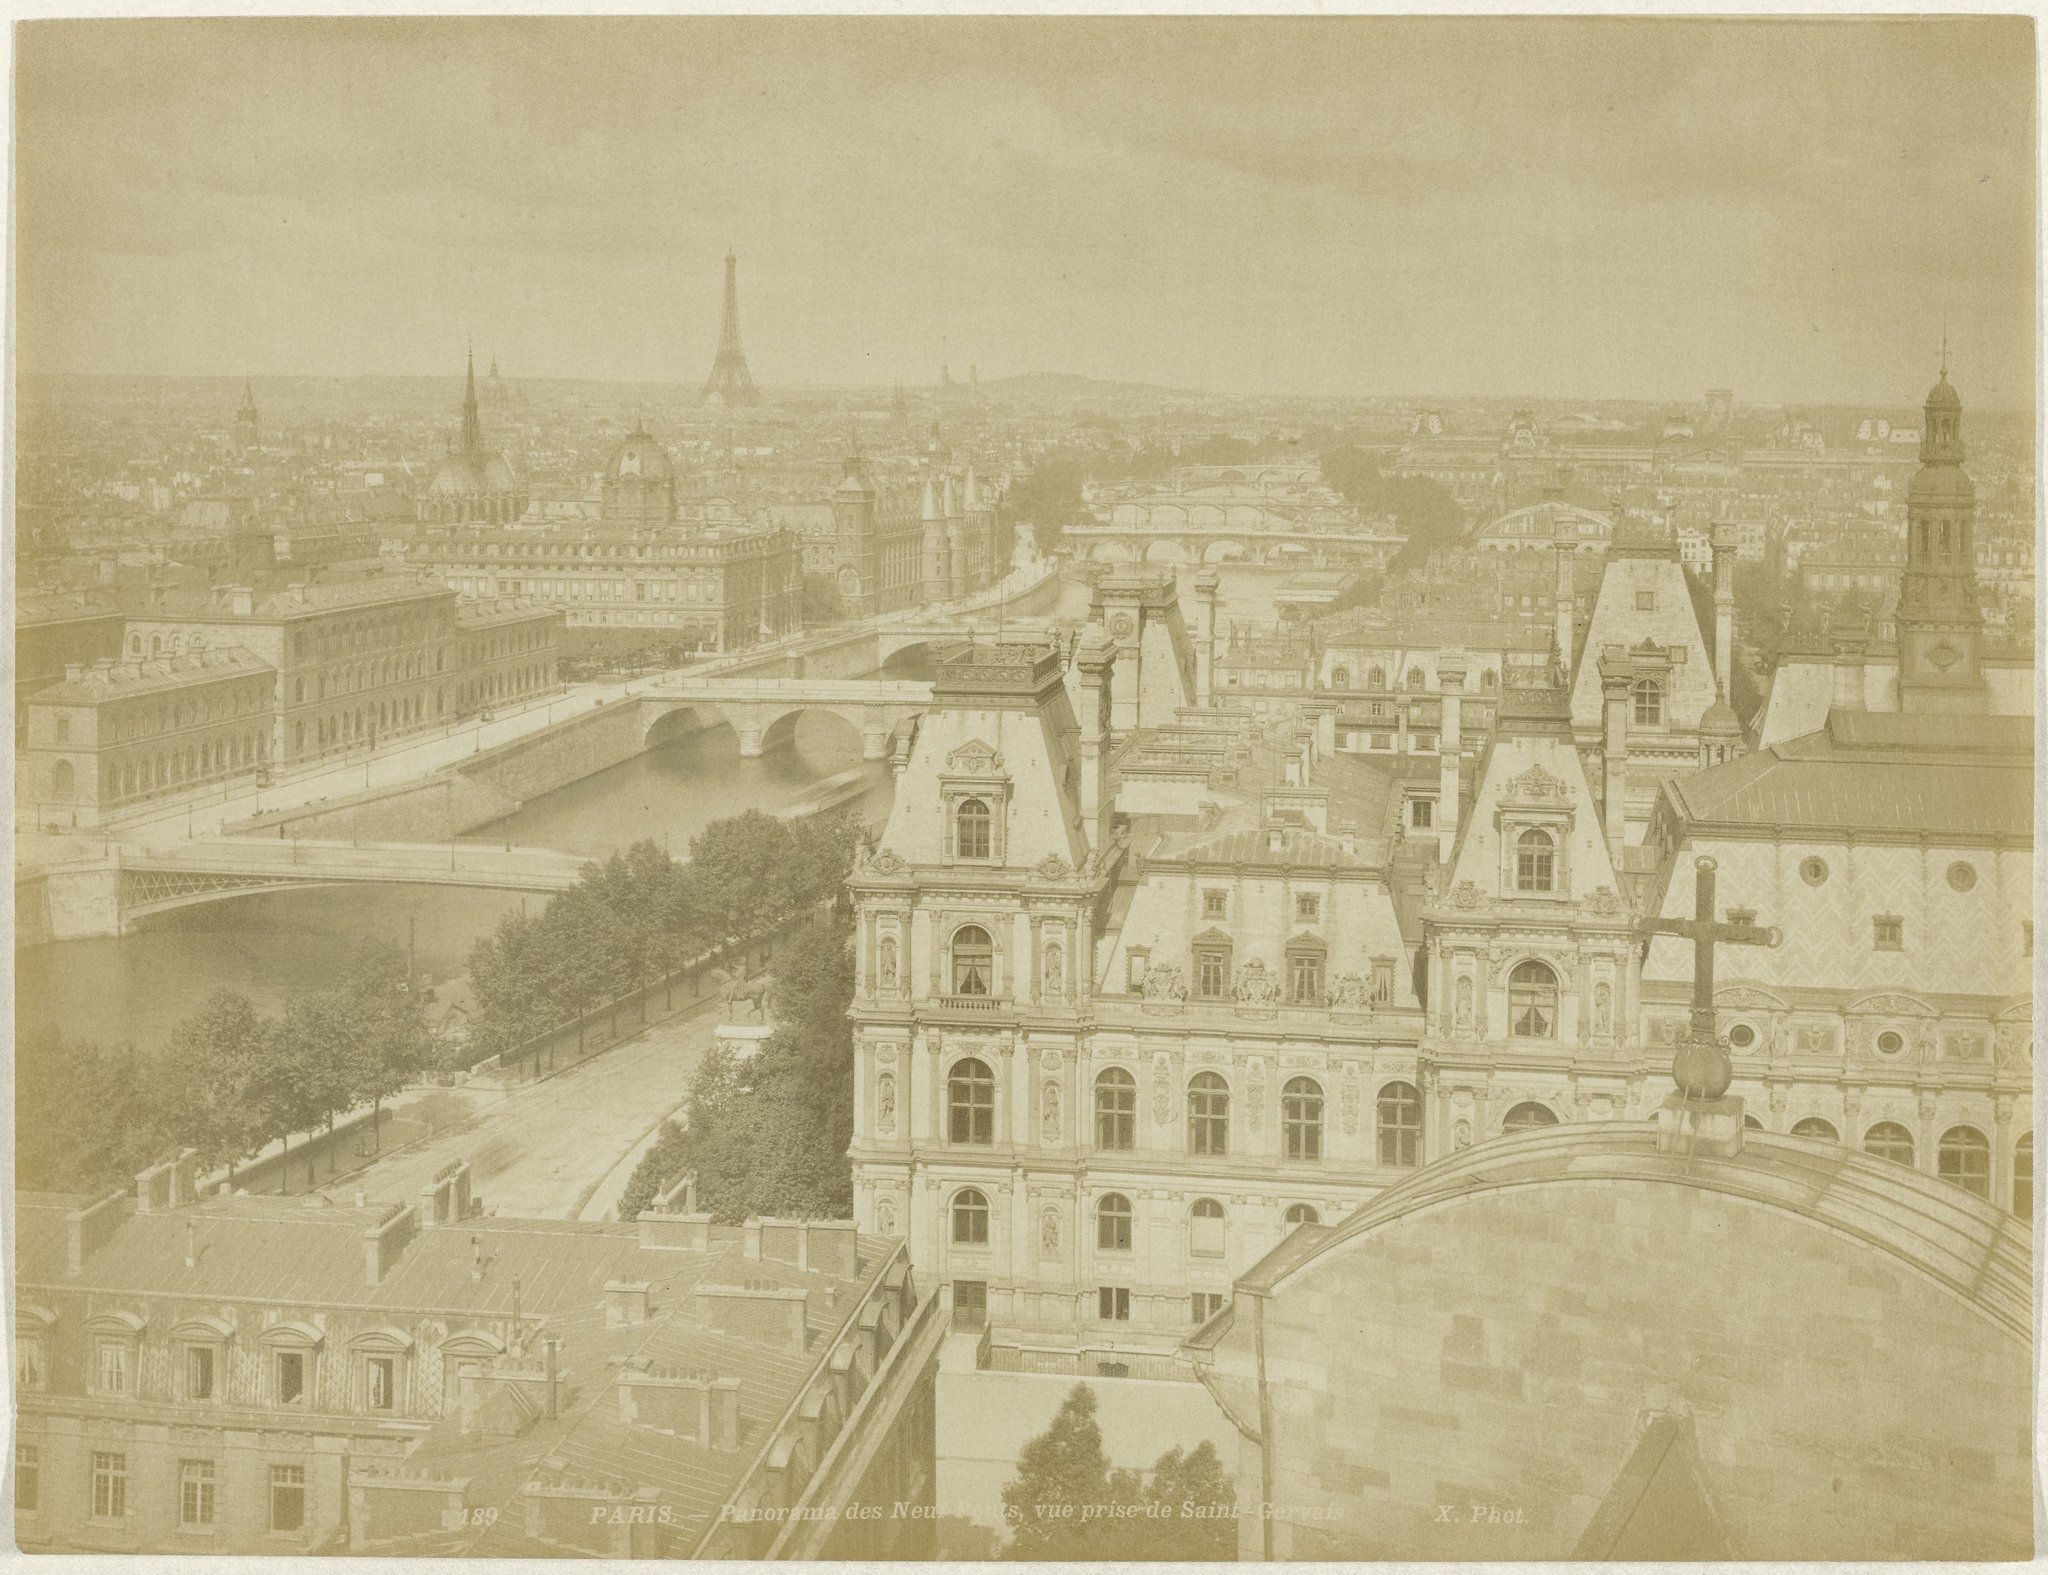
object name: photograph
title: Paris. - Panorama des Neuf Ponts, vue prise de Saint-Gervais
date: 1889-1900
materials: paper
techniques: albumen print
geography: paris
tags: urban housing, city-view in general; 'veduta', bridge in city across river, canal, etc., paris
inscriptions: inscription: ‘189 Paris. - Panorama des Neuf Ponts, vue prise de Saint-Gervais X. Phot.’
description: Tussen 1887 en ca. 1900 werkten Neurdein frères onder andere onder de naam 'X phot.'.